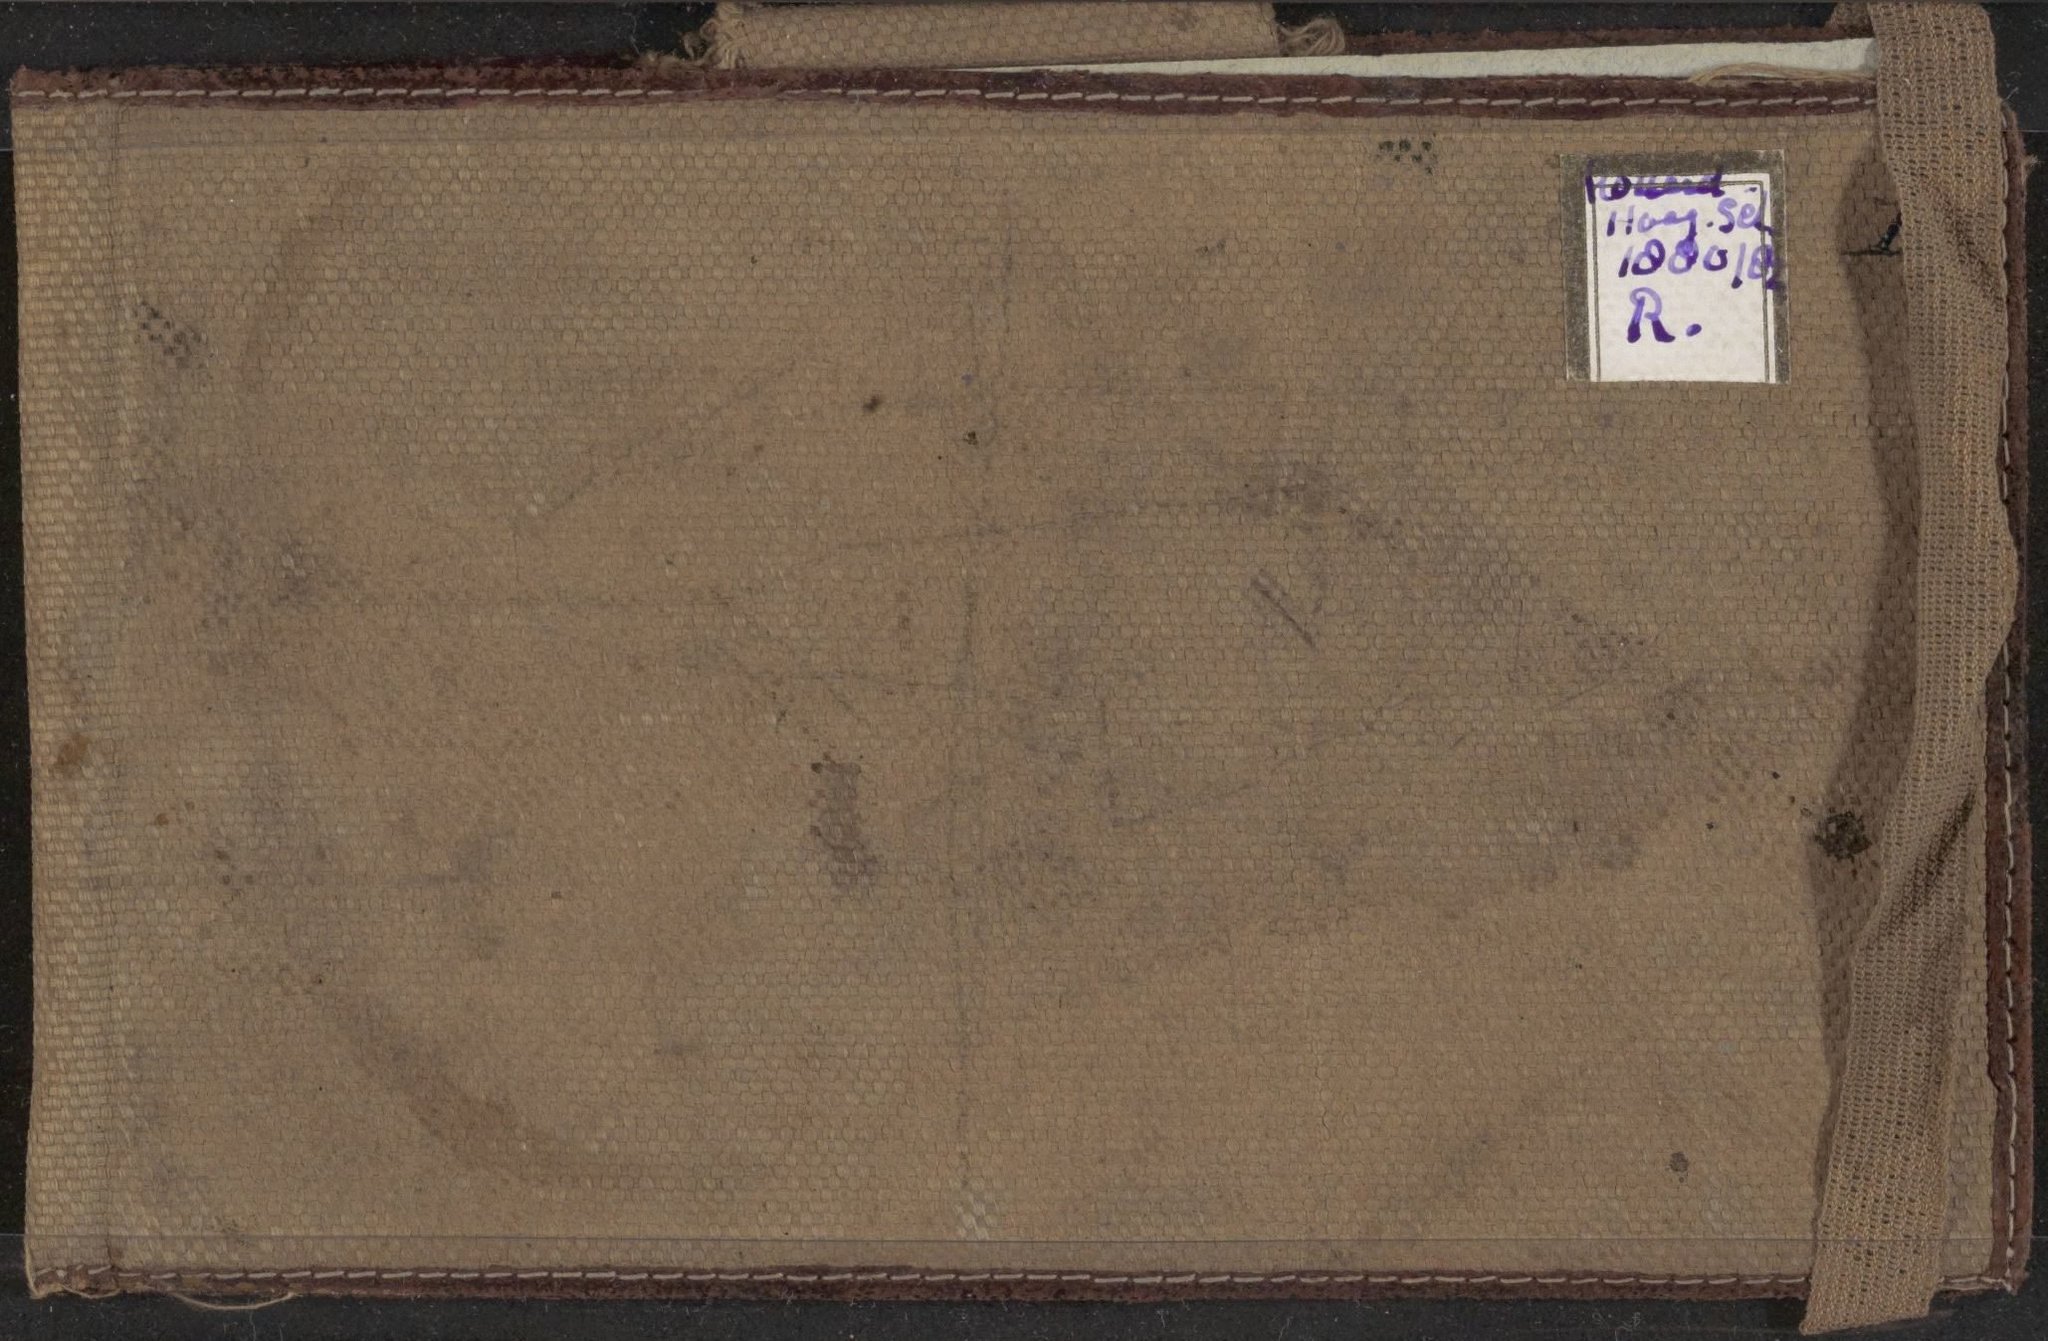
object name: sketchbook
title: Schetsboek met 16 bladen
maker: george hendrik breitner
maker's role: draughtsman, painter, print maker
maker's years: 1857-1923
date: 1880-1882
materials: cardboard, chalk, leather, linen, paper, pencil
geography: scheveningen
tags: adult woman, cat, adult man, dog, the hague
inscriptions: collector's mark: Lugt 2228, date: ‘1880/82’, annotation: ‘Rotterd./ Haag. Sch./ 1880/82/ R./ I’, workshop stamp: Lugt 291d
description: Schetsboek bestaande uit 16 bladen met dieren en figuren.